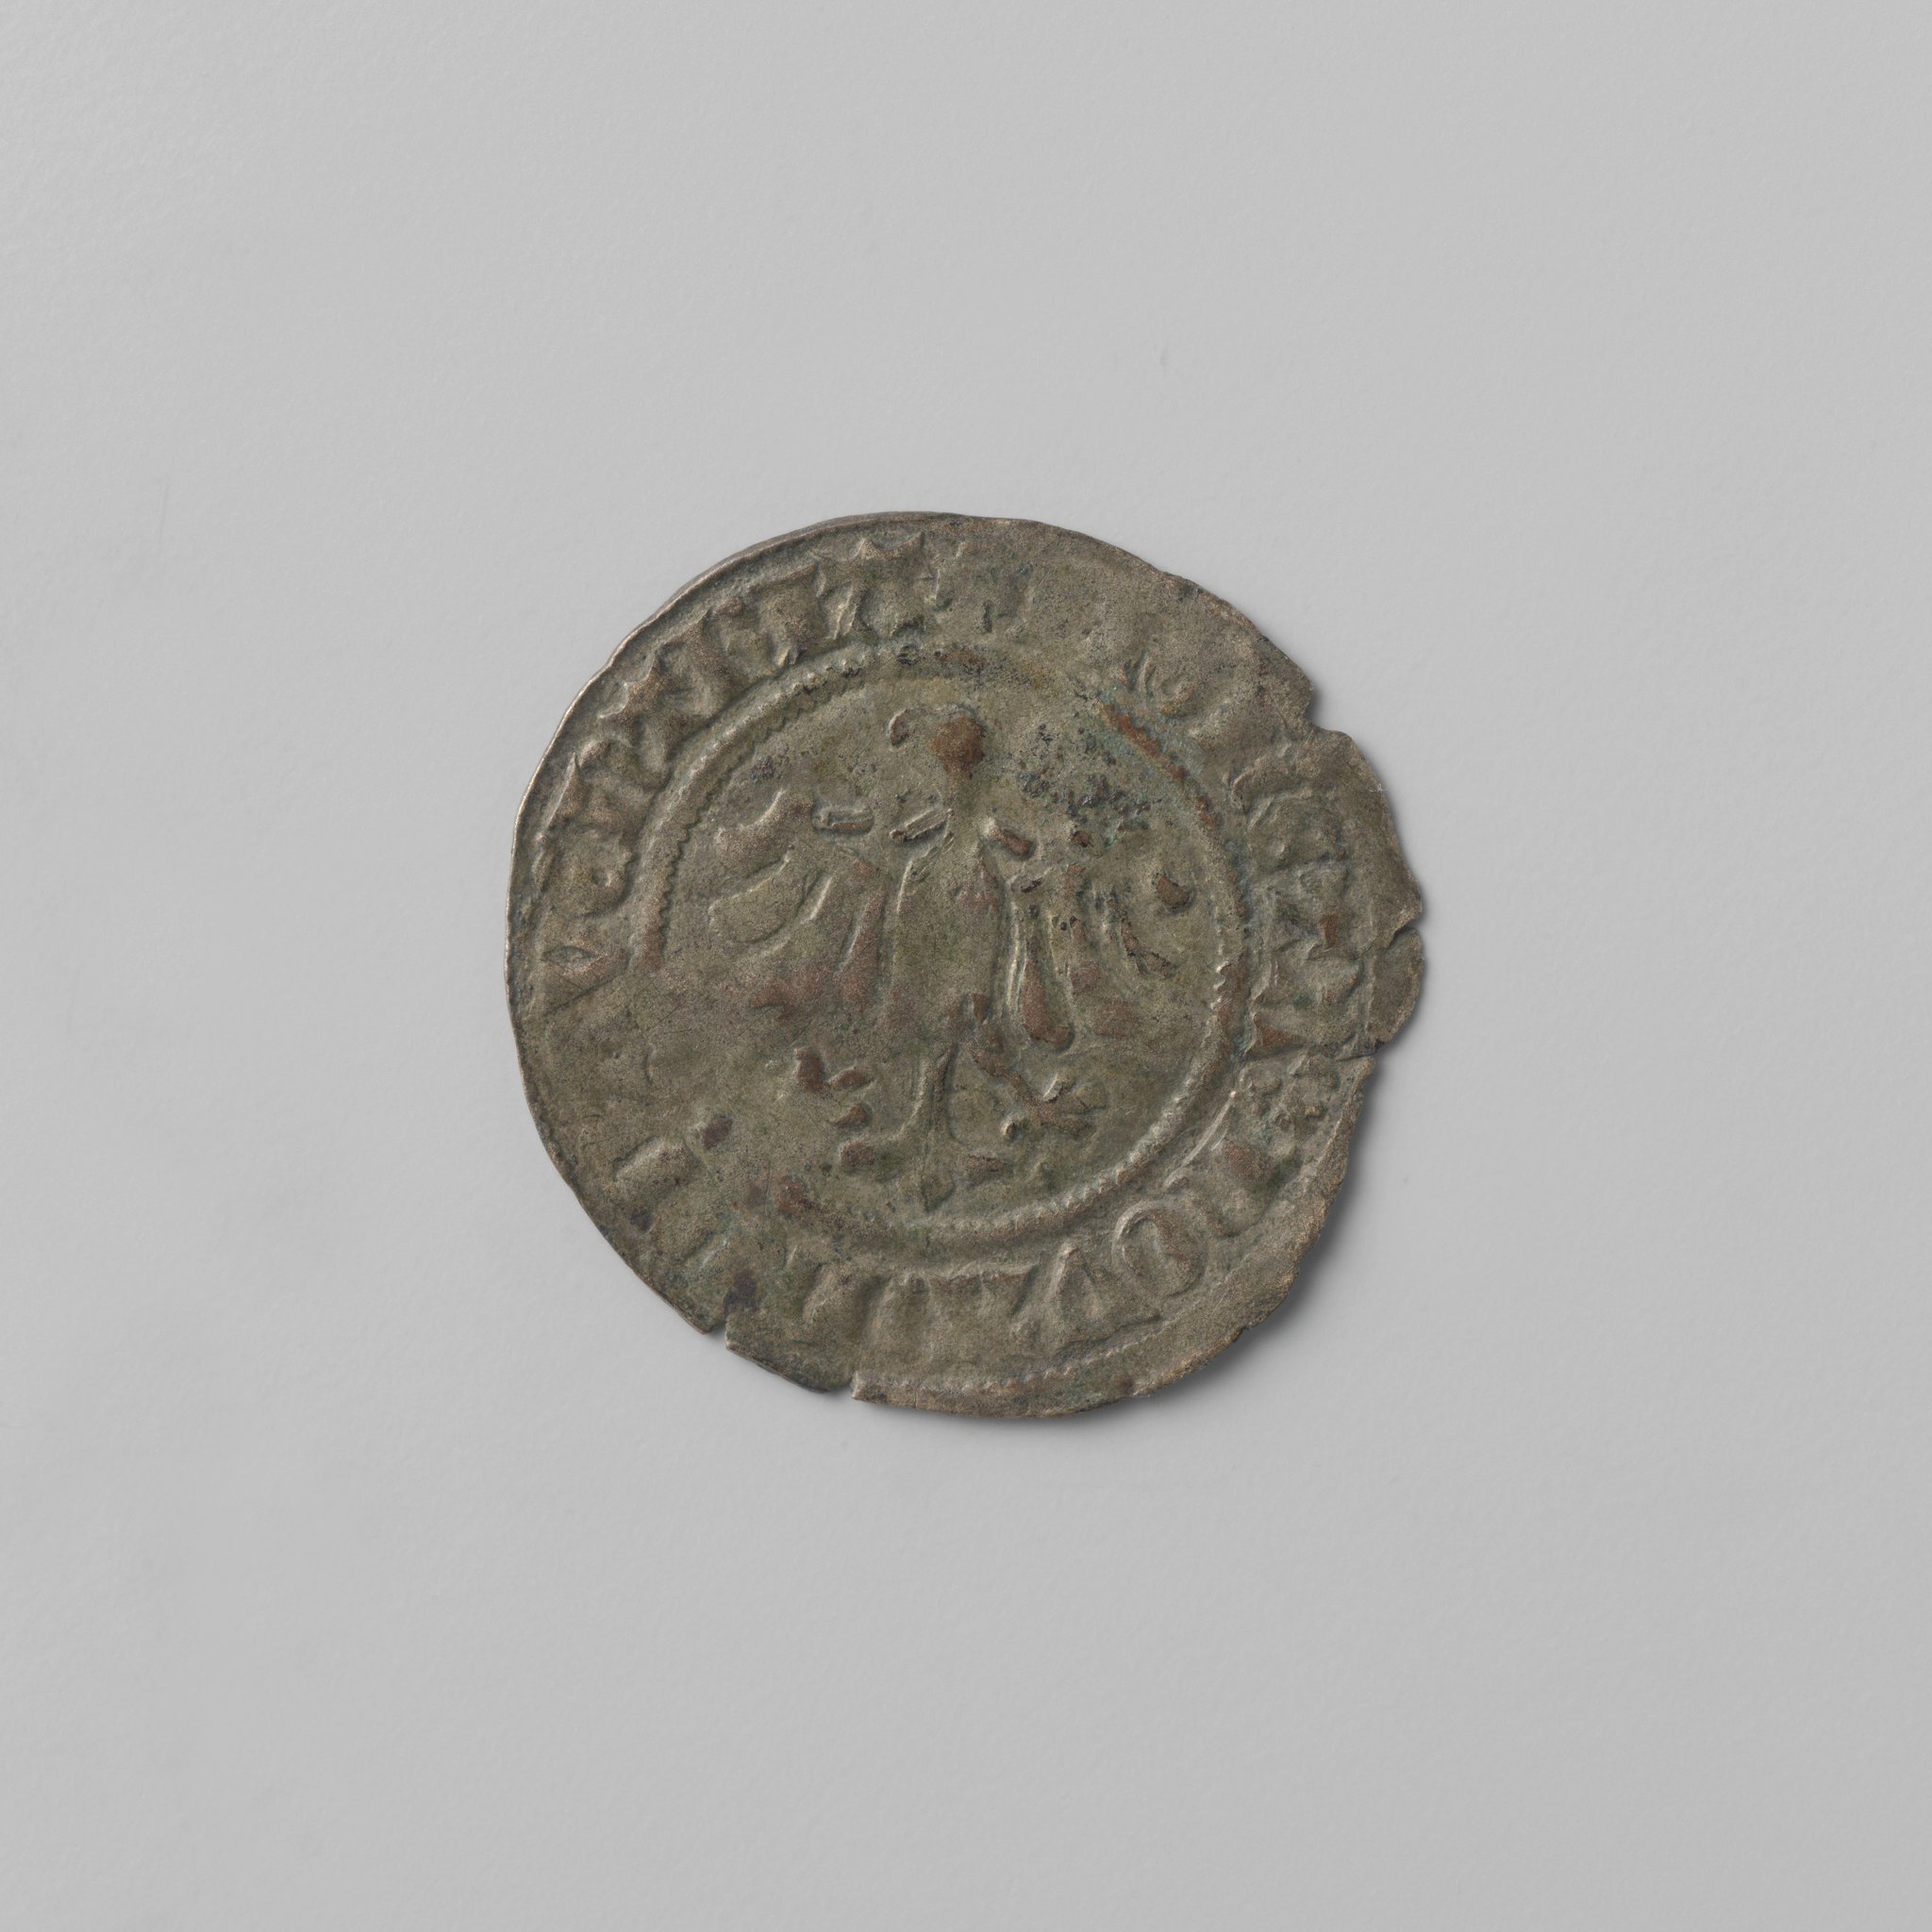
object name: coin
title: Utrechtse halve groot van Frederik van Blankenheim, 1393-1423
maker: frederik van blankenheim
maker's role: bisschop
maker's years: 1355-1423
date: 1393-1423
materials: silver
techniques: striking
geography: deventer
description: Zilveren munt. Voorzijde: helm met helmteken, waaronder twee naar elkaar toegewende wapenschilden van Utrecht en van Blankenheim. Keerzijde: adelaar.